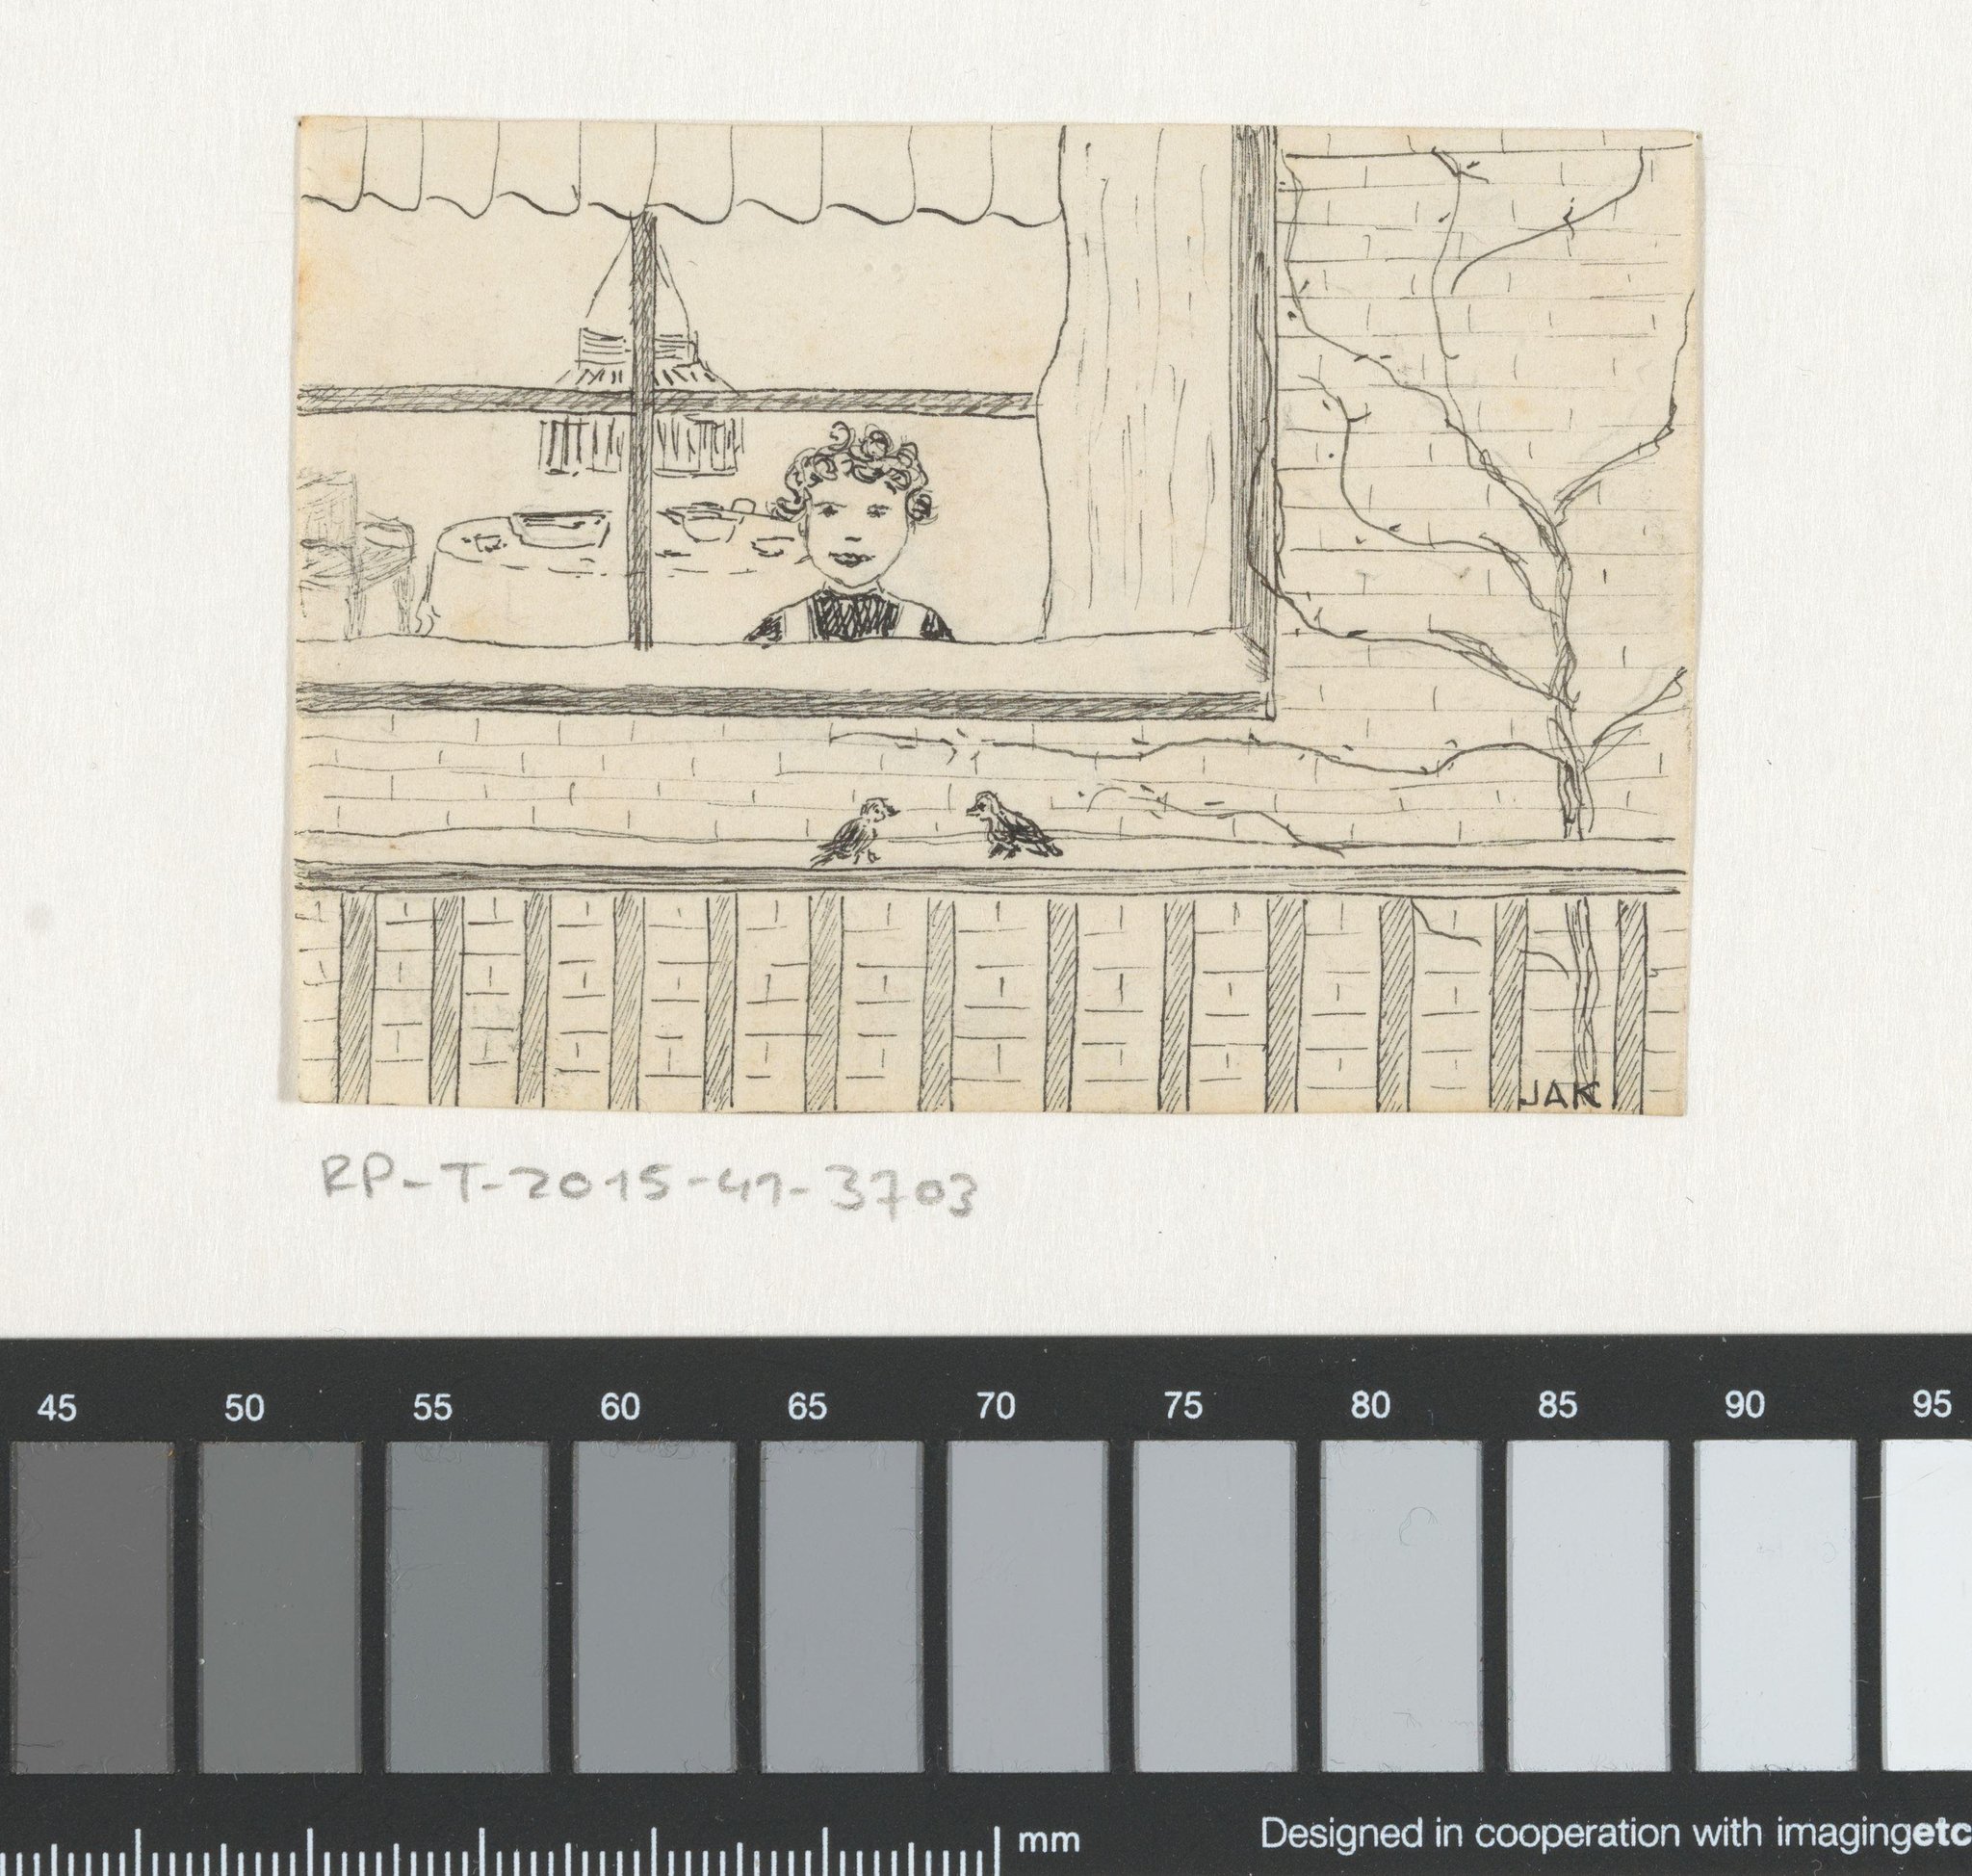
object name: drawing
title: Meisje kijkt naar twee vogels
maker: Anonymous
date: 1880-1930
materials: ink, paper, pencil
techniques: pen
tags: window, birds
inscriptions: :, collector's mark: Lugt 2228a, signature: ‘J.A.K.’, annotation: ‘Bij Benny's vrienden’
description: Een meisje kijkt vanuit een huis door het raam naar twee vogels op een hek.